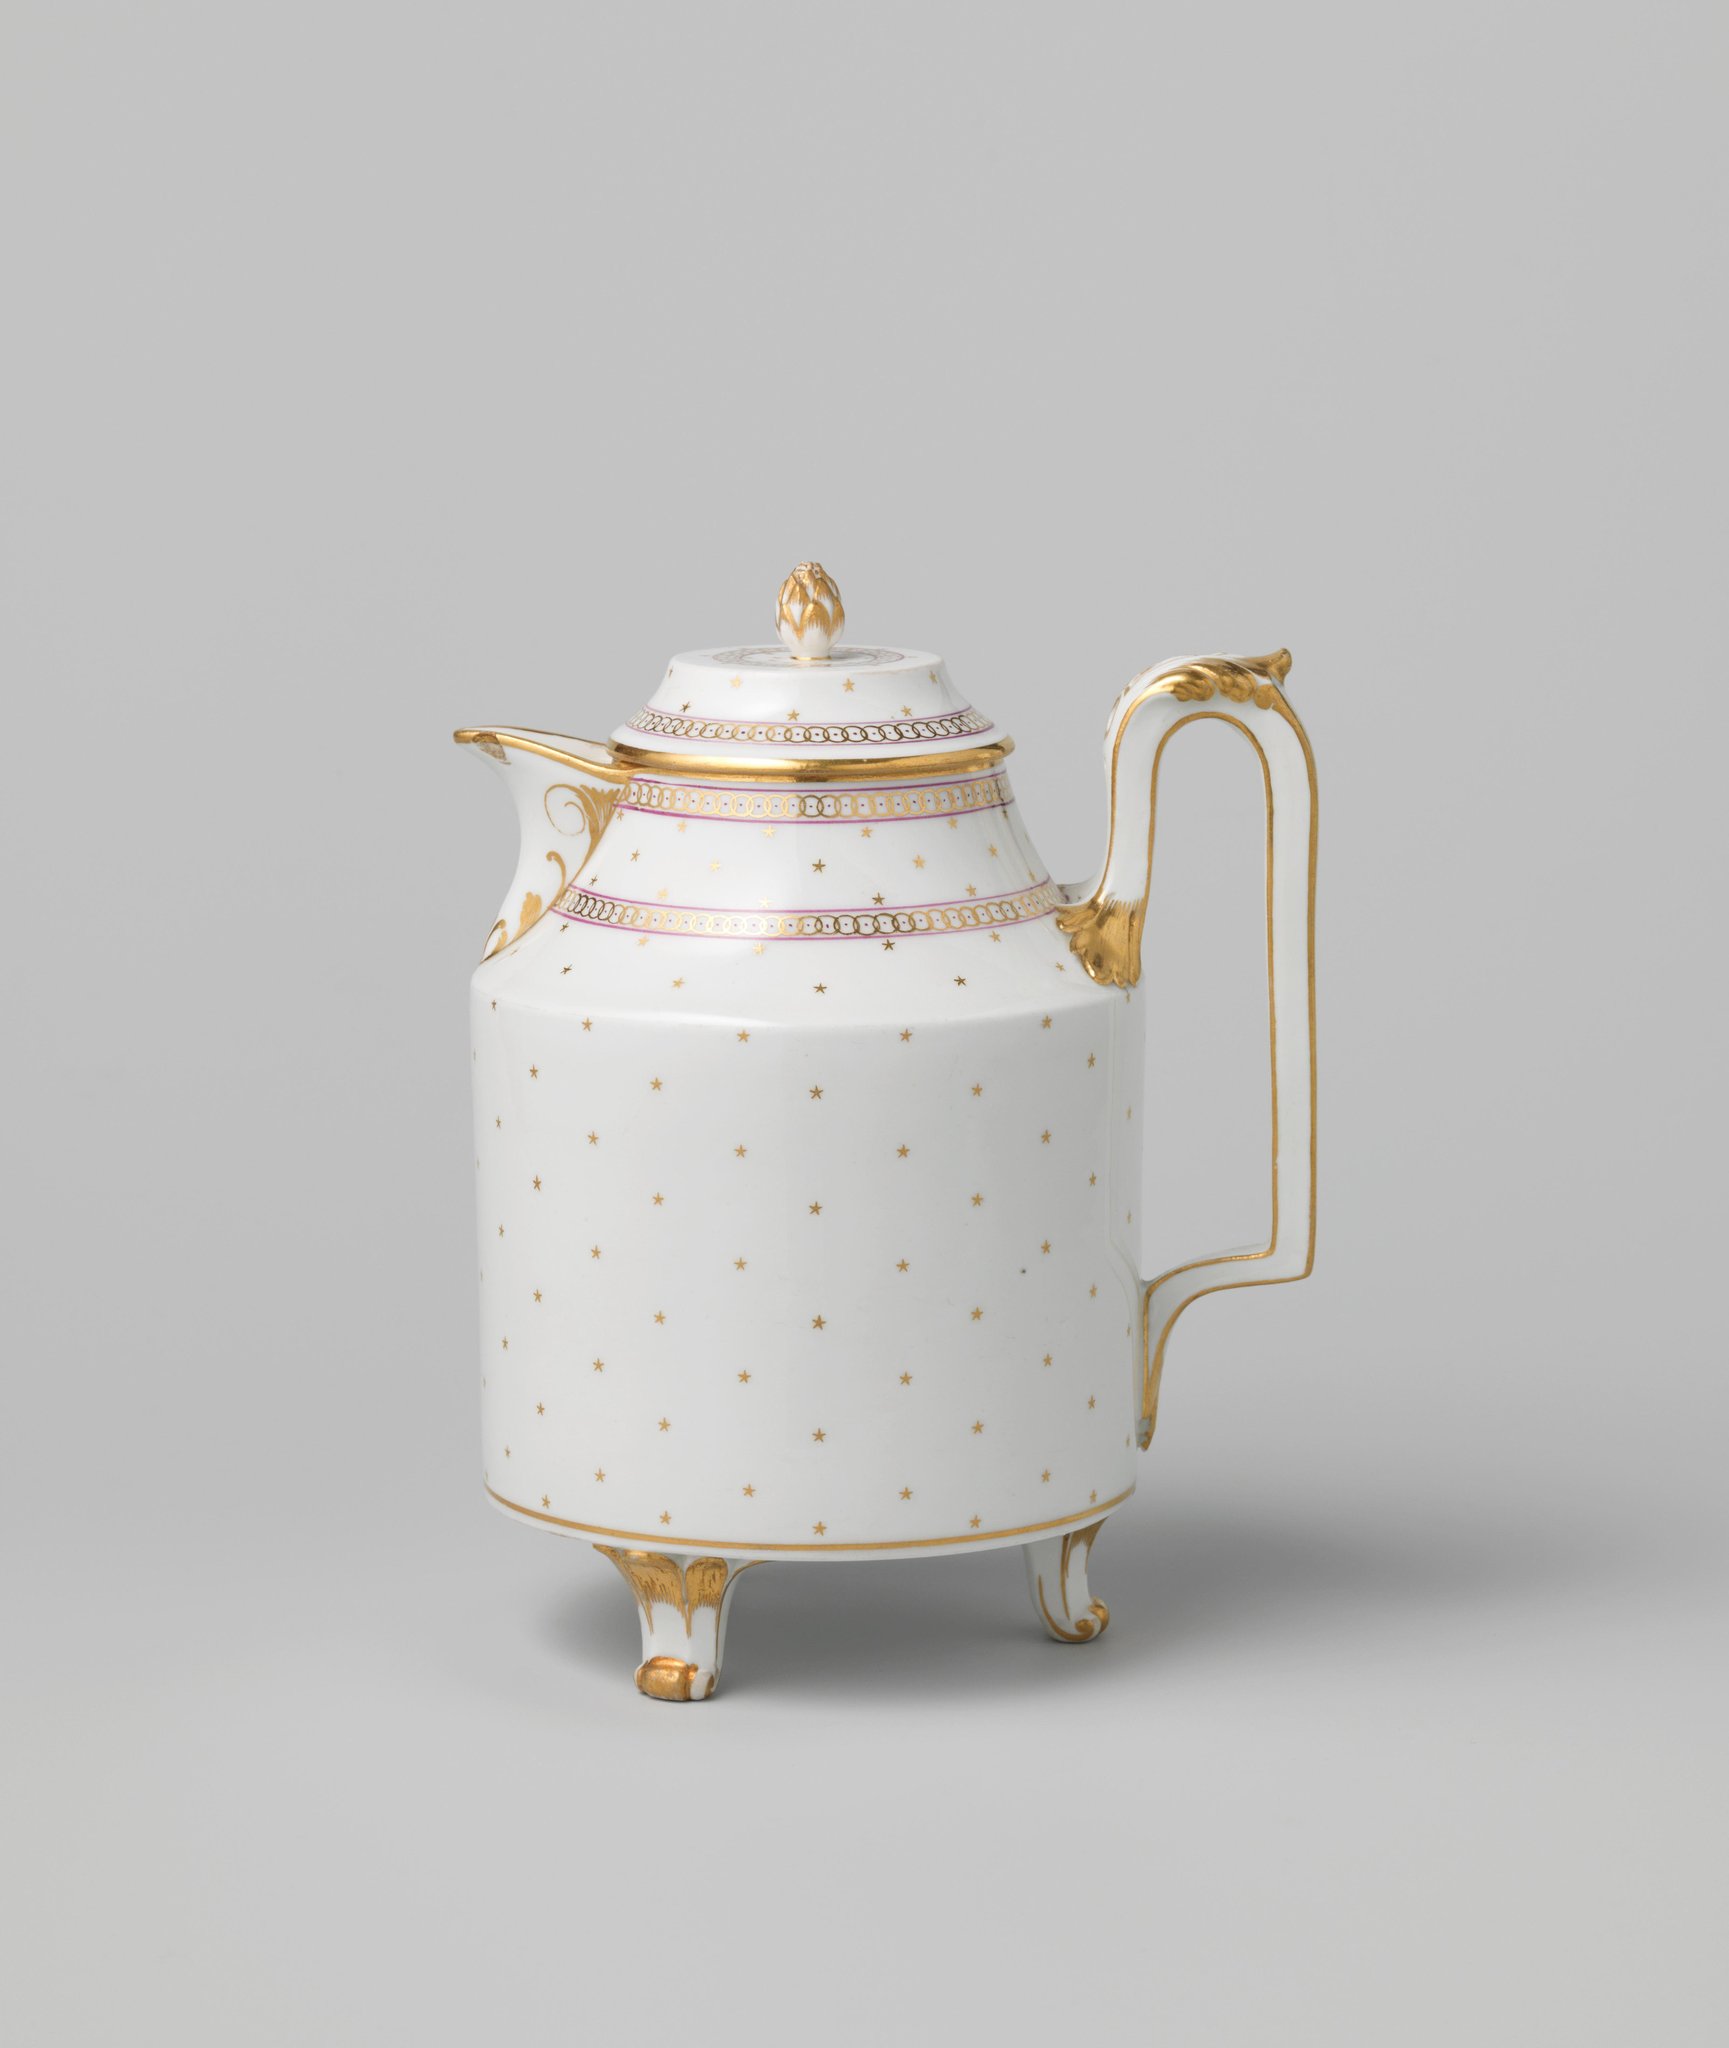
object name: ewer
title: Koffiekan with stars and ornamental borders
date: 1791-1801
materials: glaze, gold, paint, porcelain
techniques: firing, forming, gilding, turning, vitrification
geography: vienna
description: Coffee pot. Porcelain. Vienna, 1801. Given by Mrs J.E.F.E. de Kleyn-von Artner, 1956.